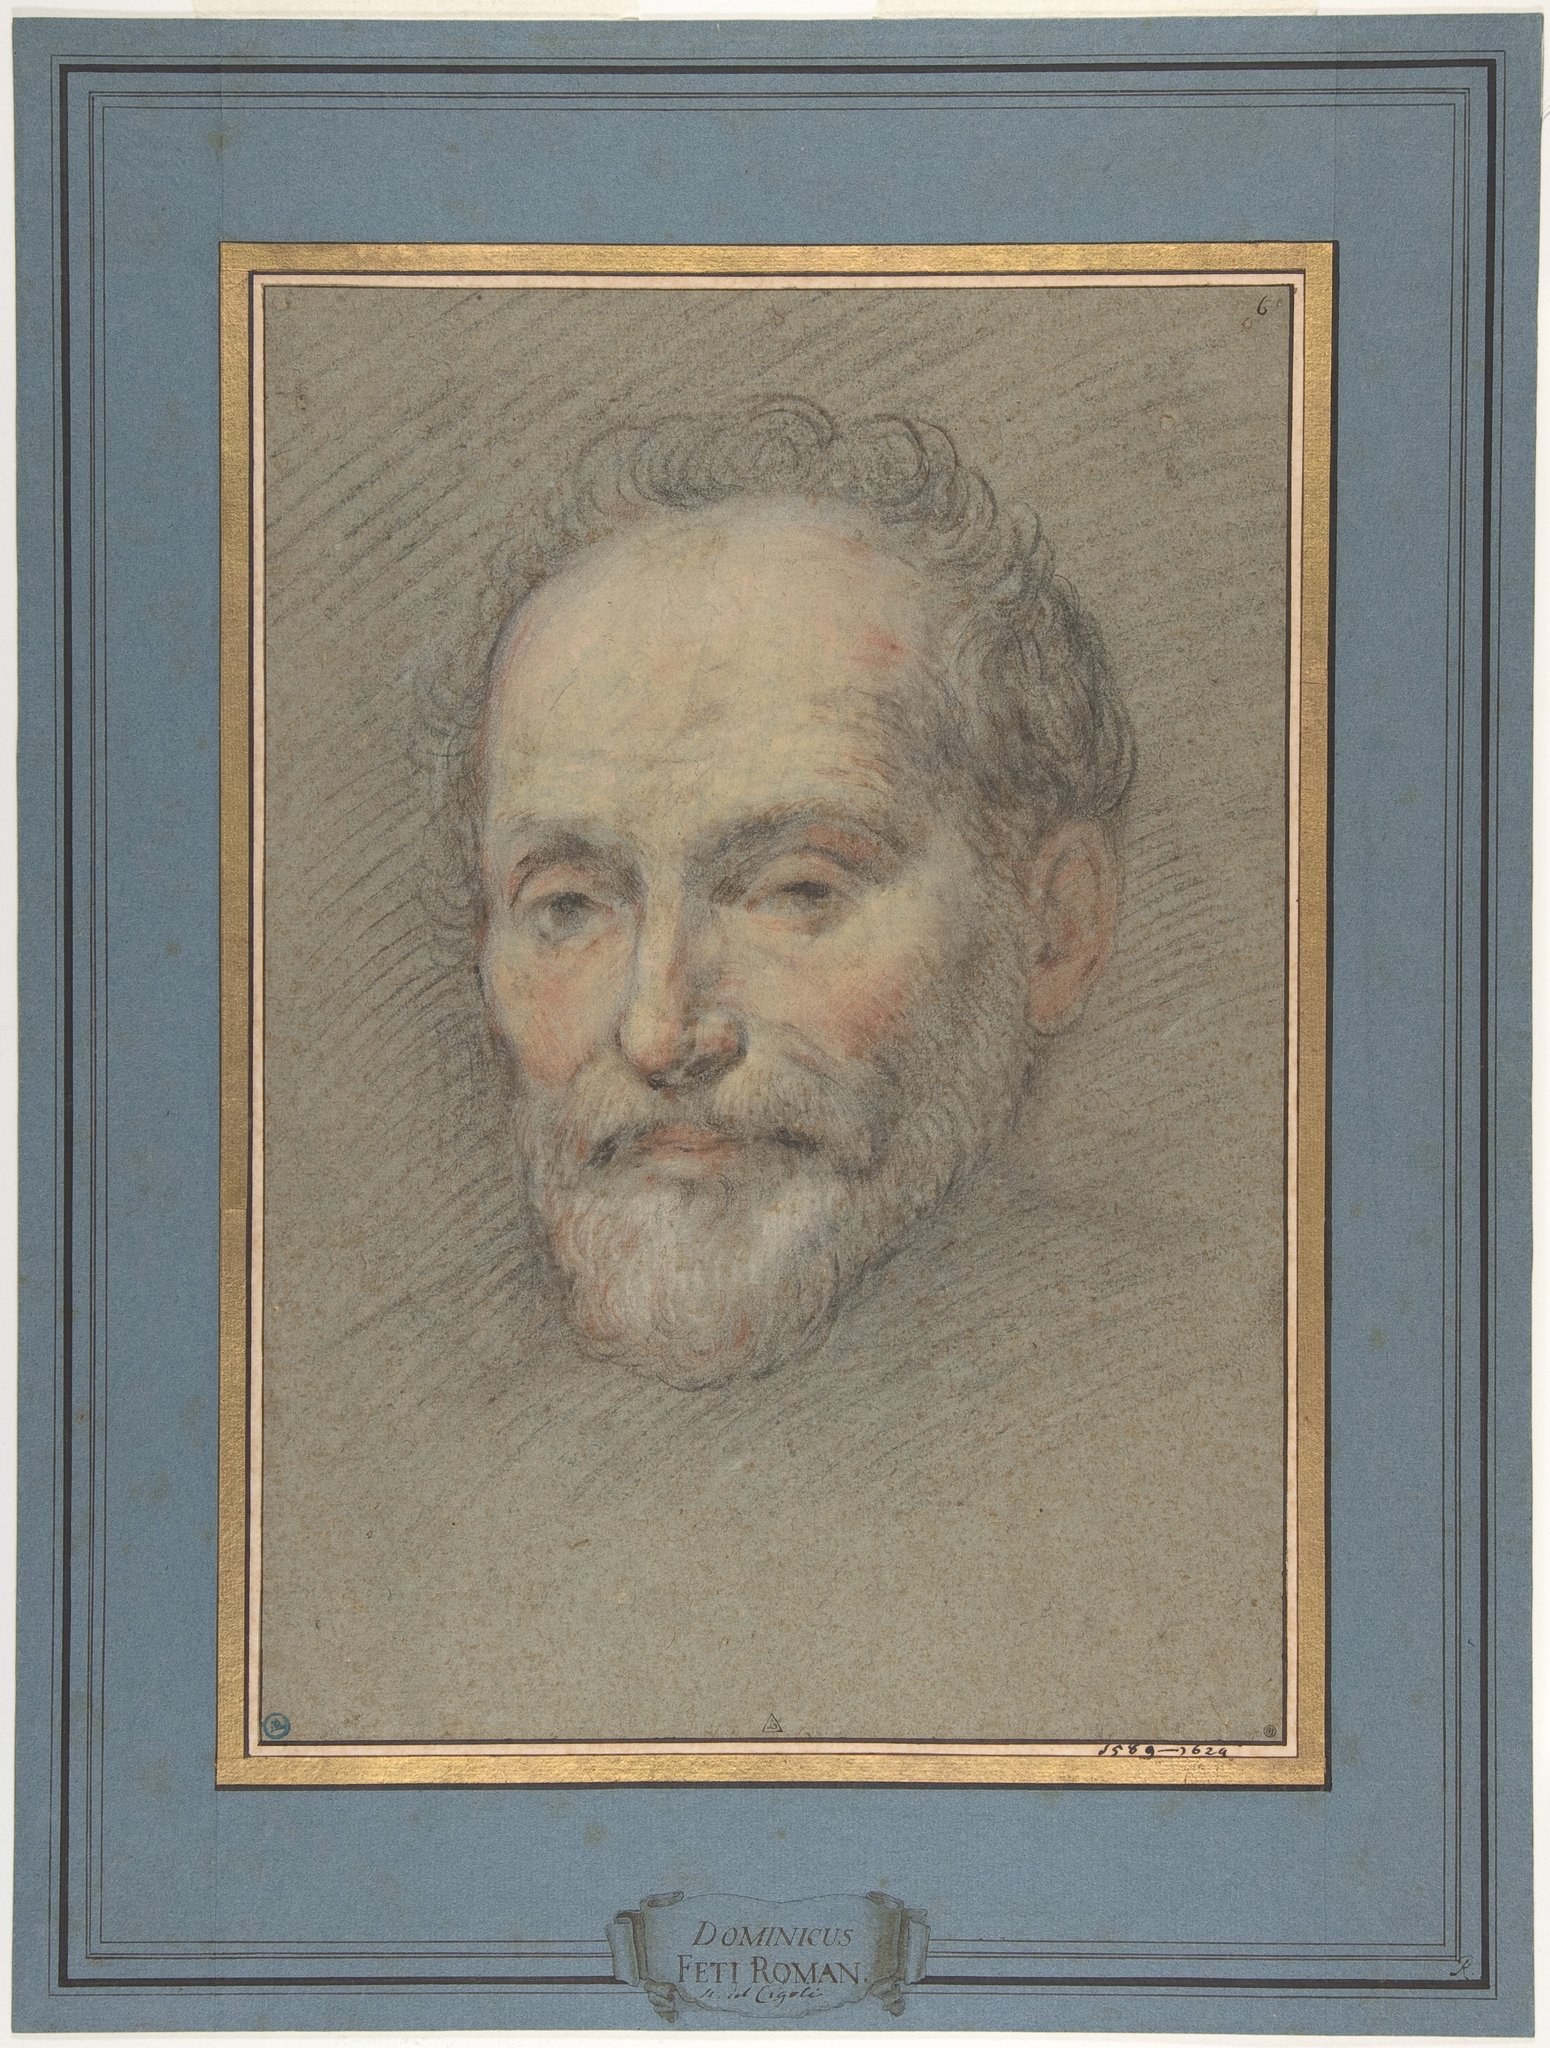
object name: drawing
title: Head of a Bearded Man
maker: domenico fetti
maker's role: artist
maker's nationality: italian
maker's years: 1591-1623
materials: chalk, paper, pastel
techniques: highlighting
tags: heads,men,portraits